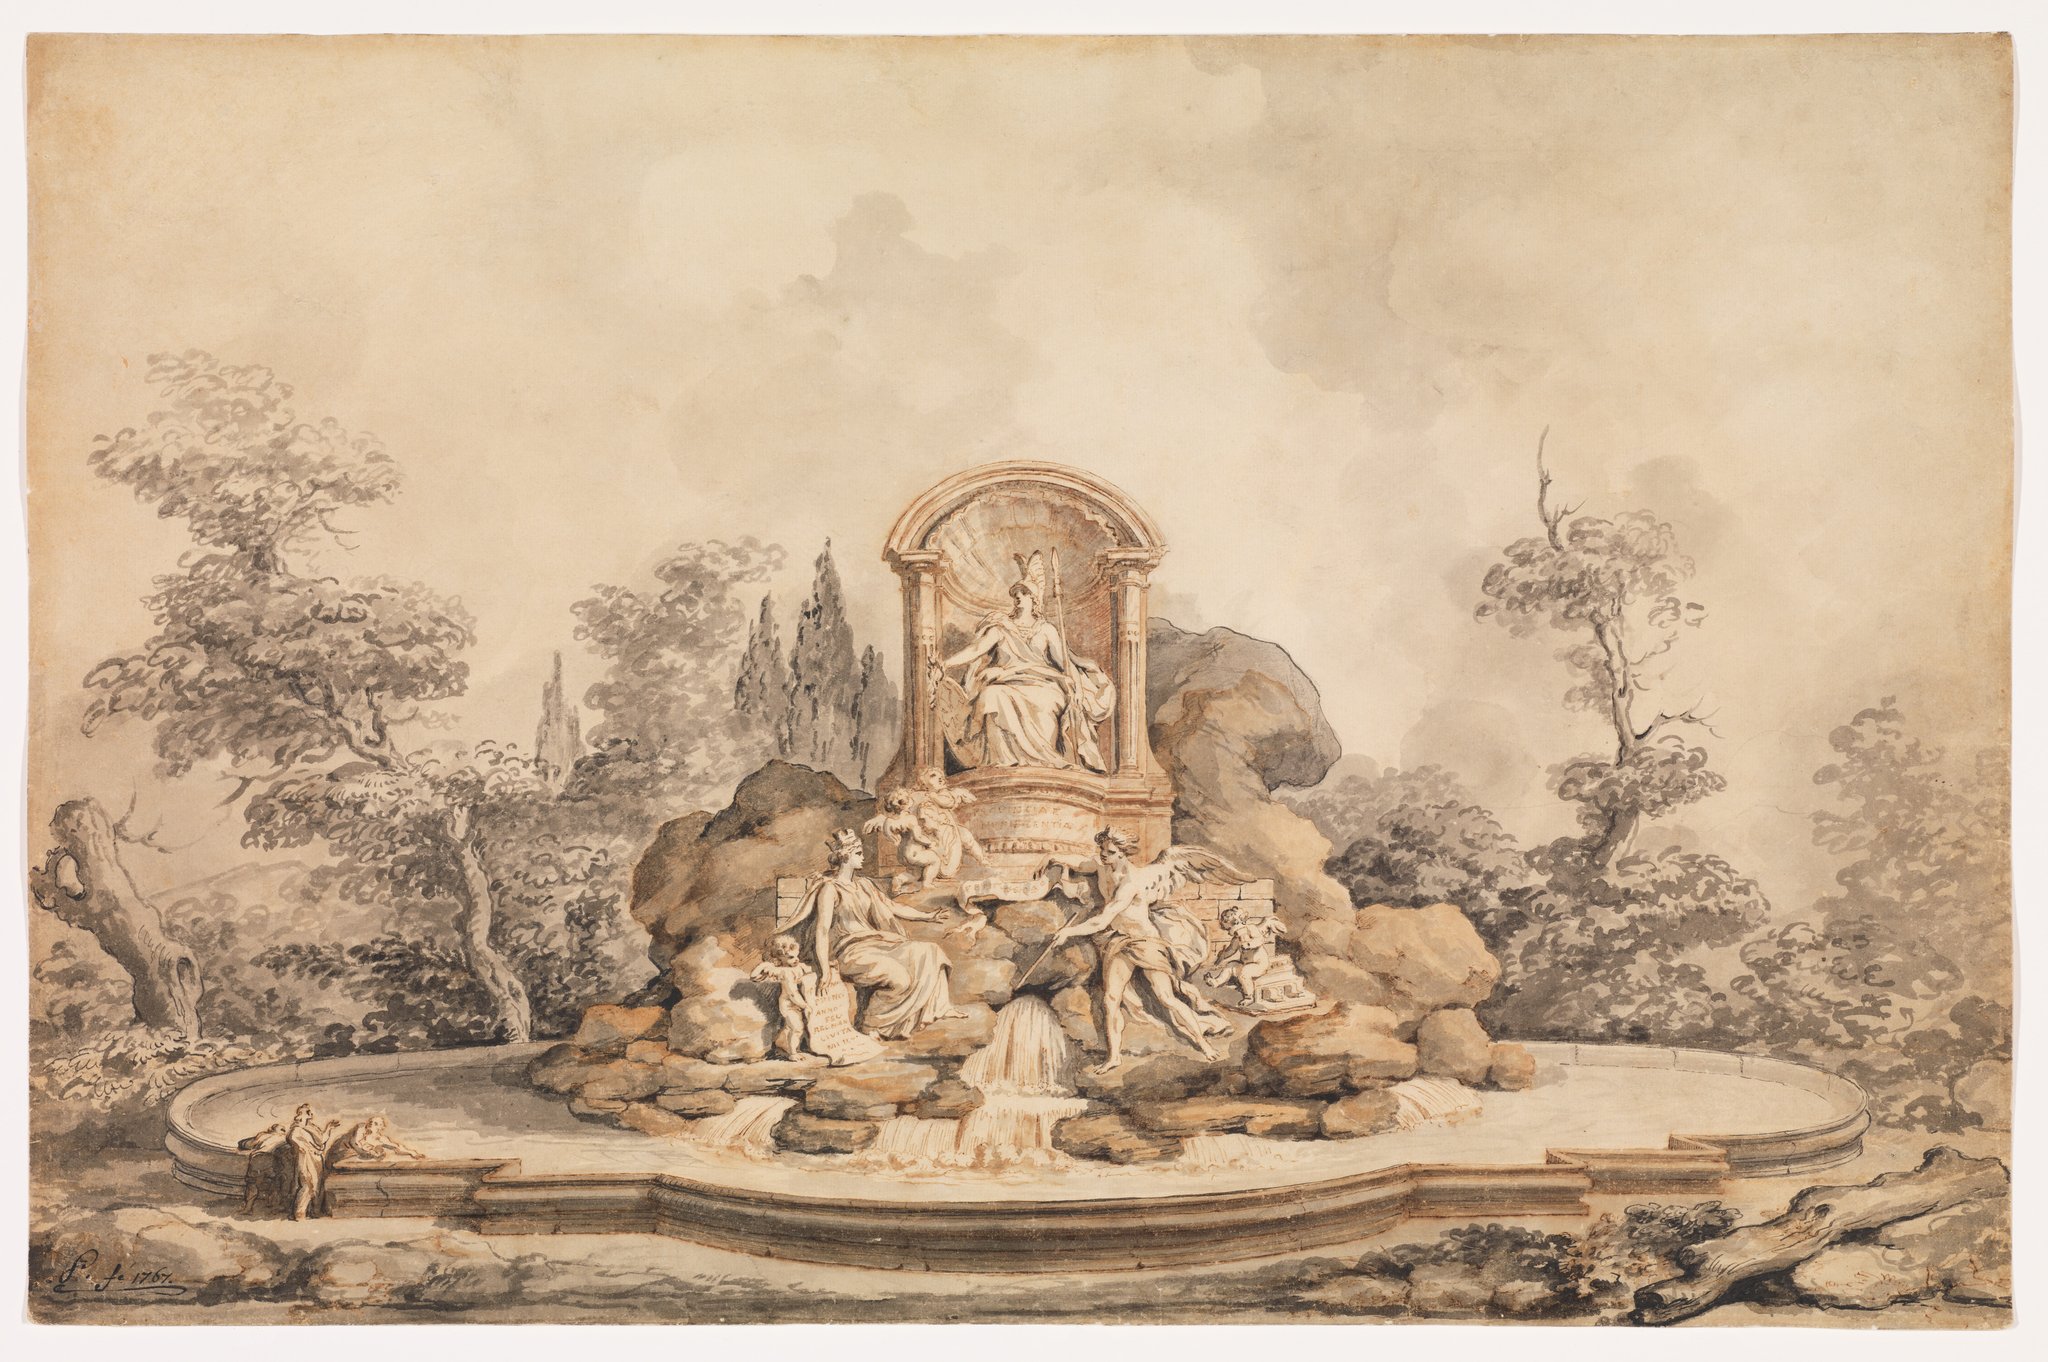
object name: drawing ornament architecture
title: Project for a Monumental Fountain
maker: augustin pajou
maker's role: artist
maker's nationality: french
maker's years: 1730-1809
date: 1767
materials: ink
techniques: brush, pen, wash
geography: france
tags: fountains,men,women,trees